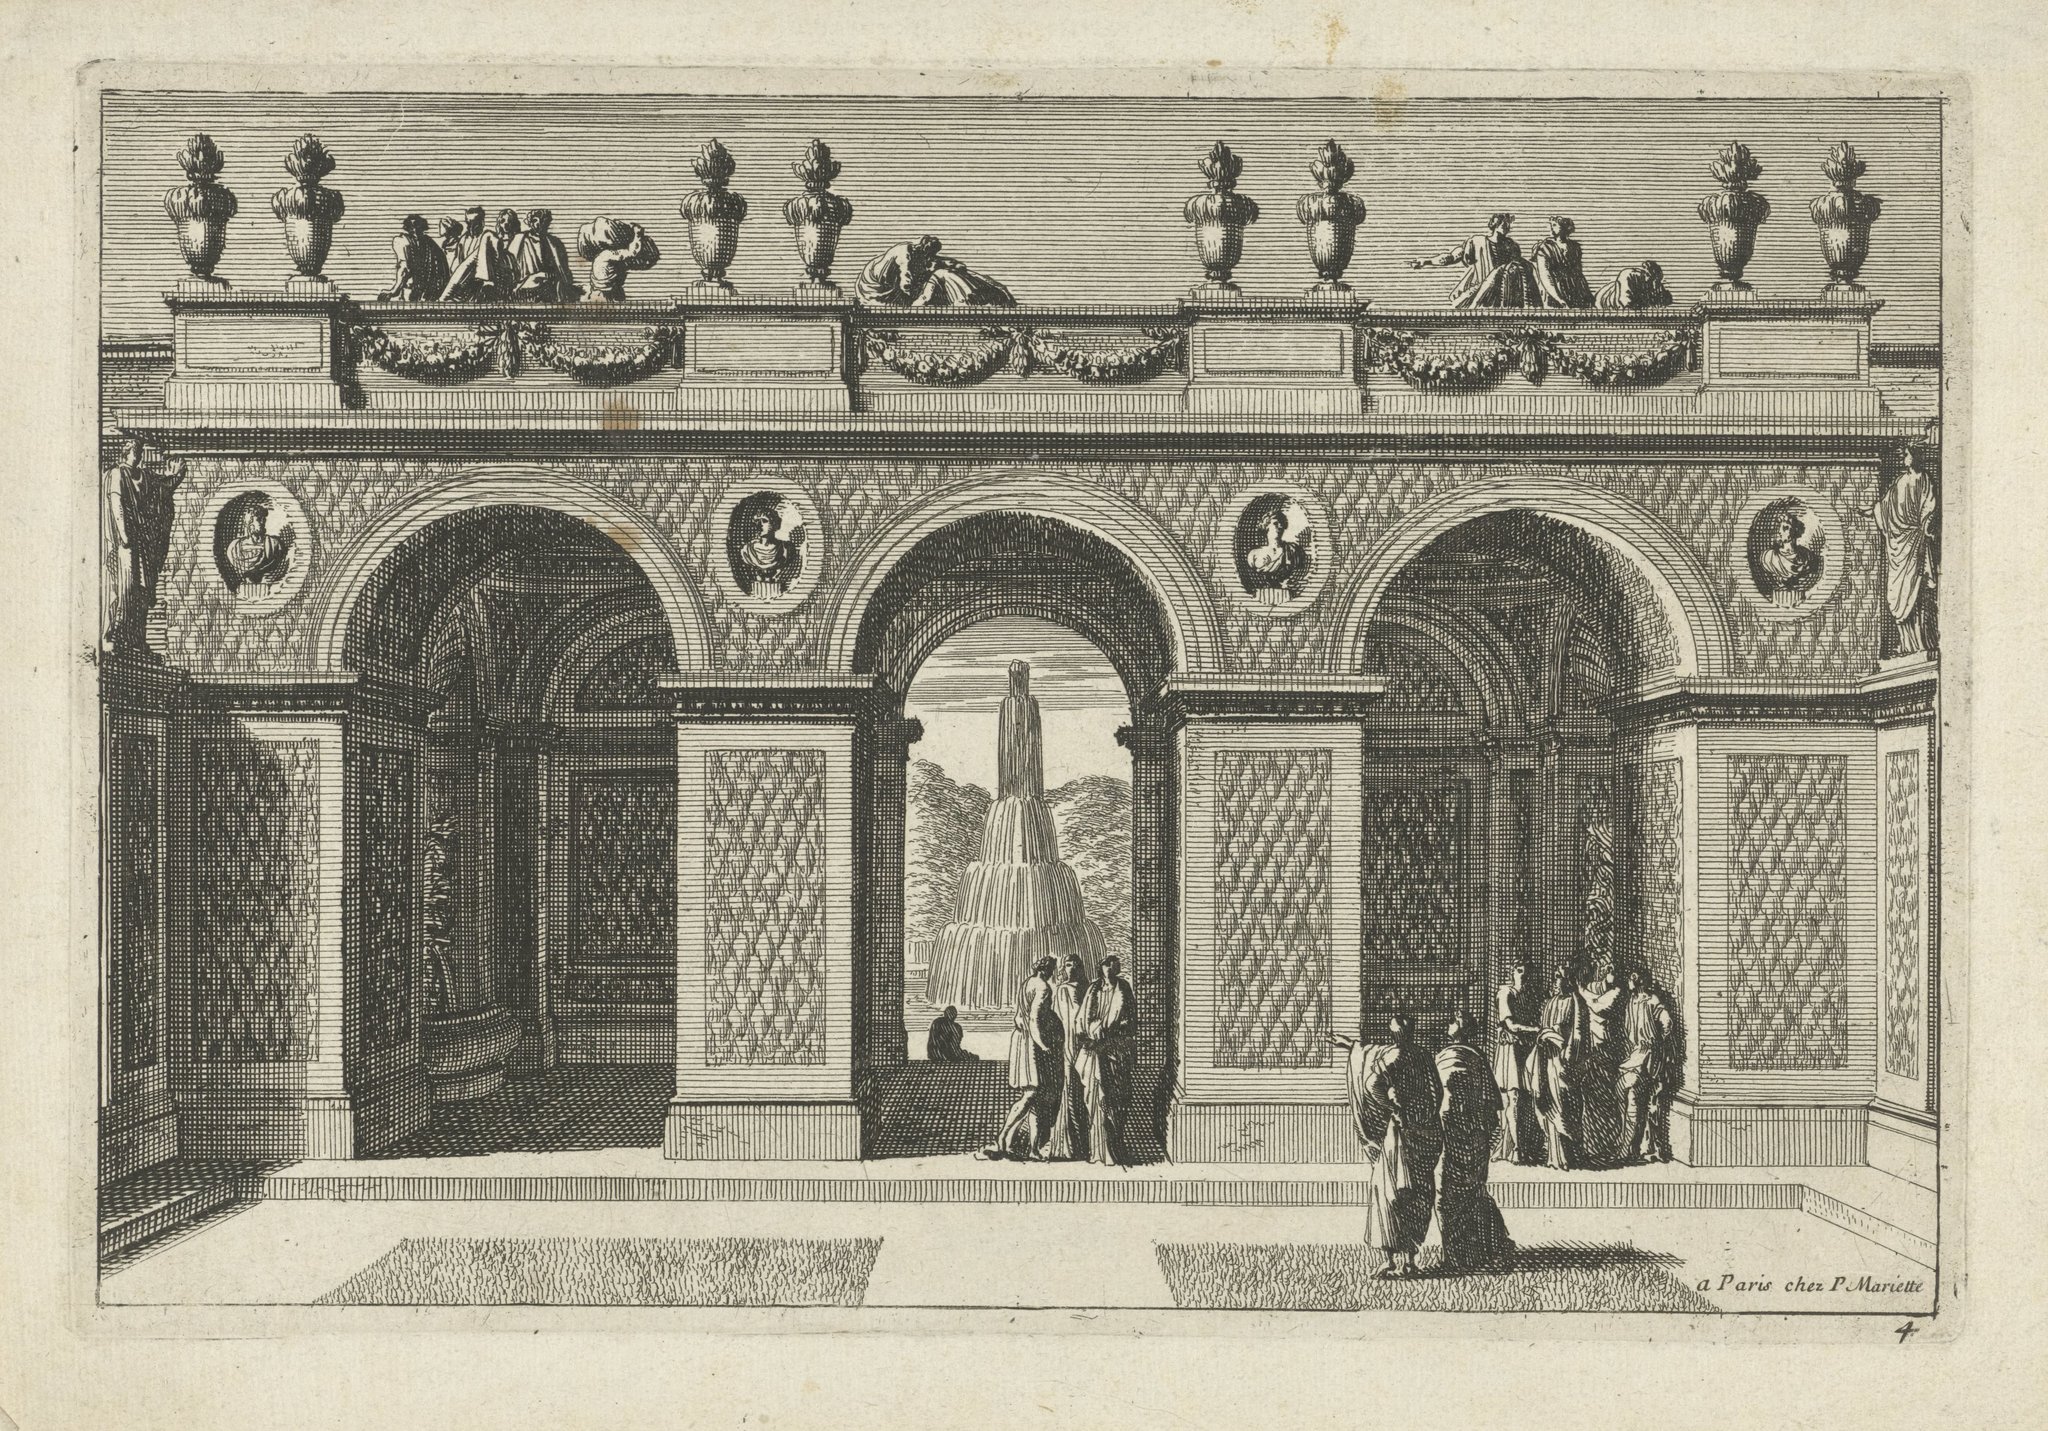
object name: ornament print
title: Veüe Grottes et Fontaines de Jardins a l'Italiene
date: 1658-1670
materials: paper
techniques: etching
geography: paris